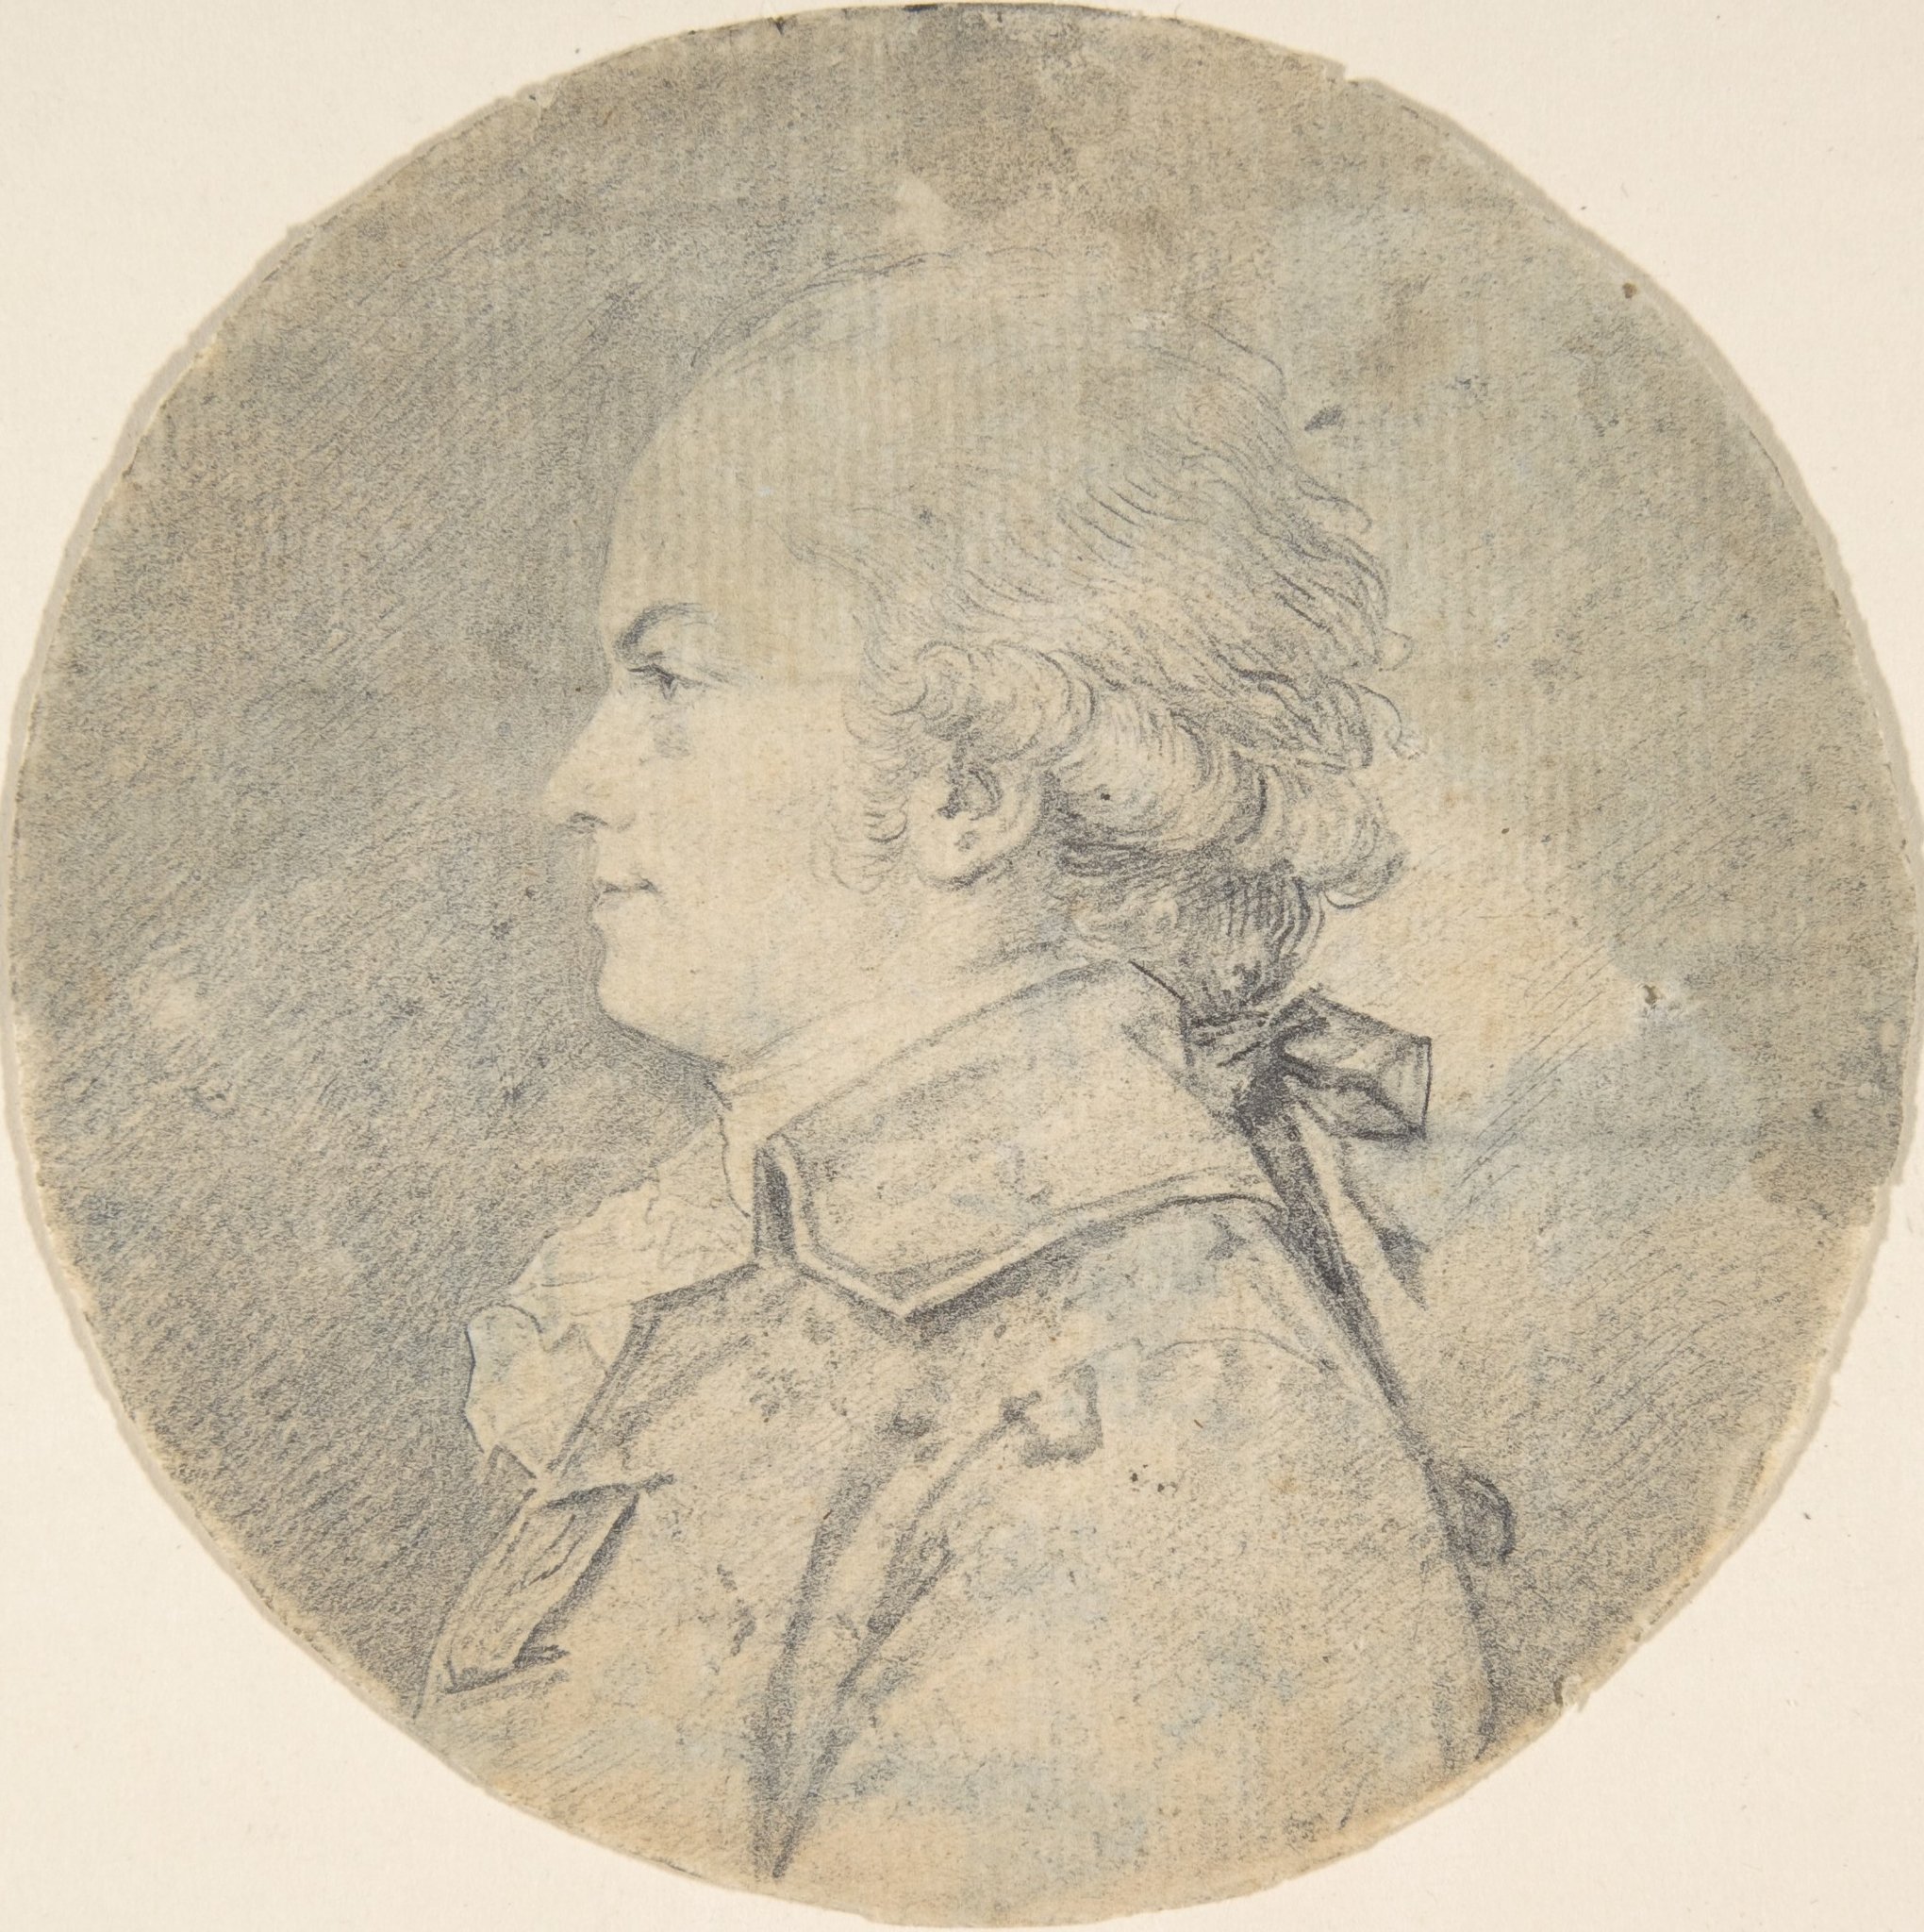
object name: drawing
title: Bust of a Man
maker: anonymous, french, 18th century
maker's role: artist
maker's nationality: french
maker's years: 1700-1800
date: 1701-1800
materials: graphite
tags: men